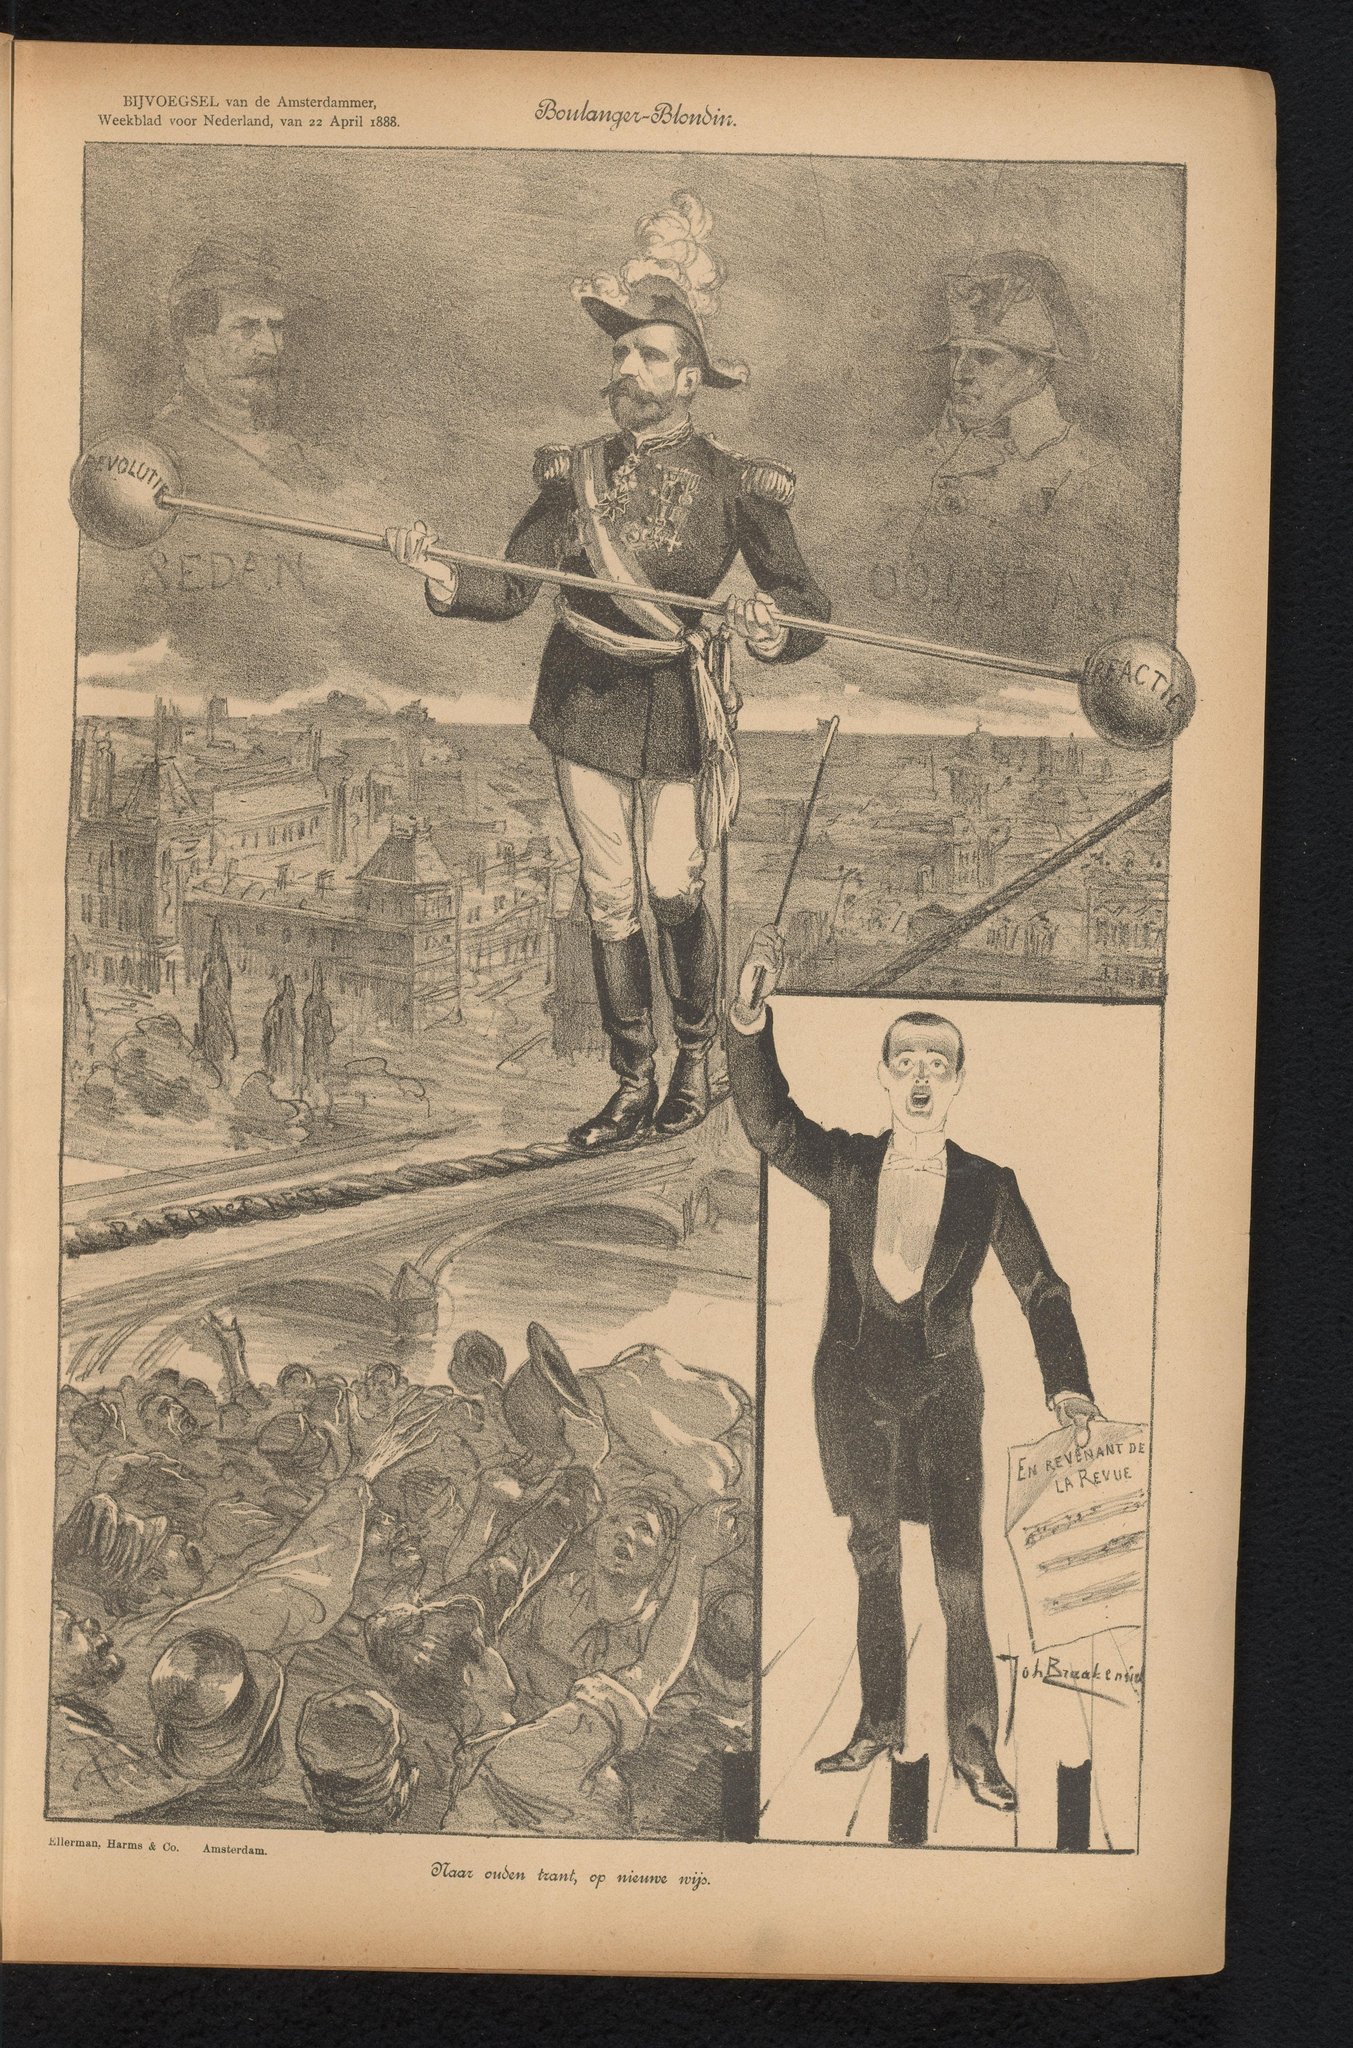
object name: cartoon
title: Boulanger-Blondin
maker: johan braakensiek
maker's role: draughtsman, print maker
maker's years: 1858-1940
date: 1888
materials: paper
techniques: lithograph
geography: netherlands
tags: historical persons, tight-ropewalker, political caricatures and satires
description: De Franse generaal en minister Georges Boulanger, een man in uniform met vele militaire onderscheidingen, als de koorddanser Charles Blondin balancerend boven een brug in een stad. In de handen een balanceerstok Revolutie - Reactie. Op de voorgrond een juichende menigte. Op de achtergrond schimmen van de nederlagen van keizer Napoleon III bij Sedan en Napoleon Bonaparte bij Waterloo. Rechtsonder een inzet met een zanger.